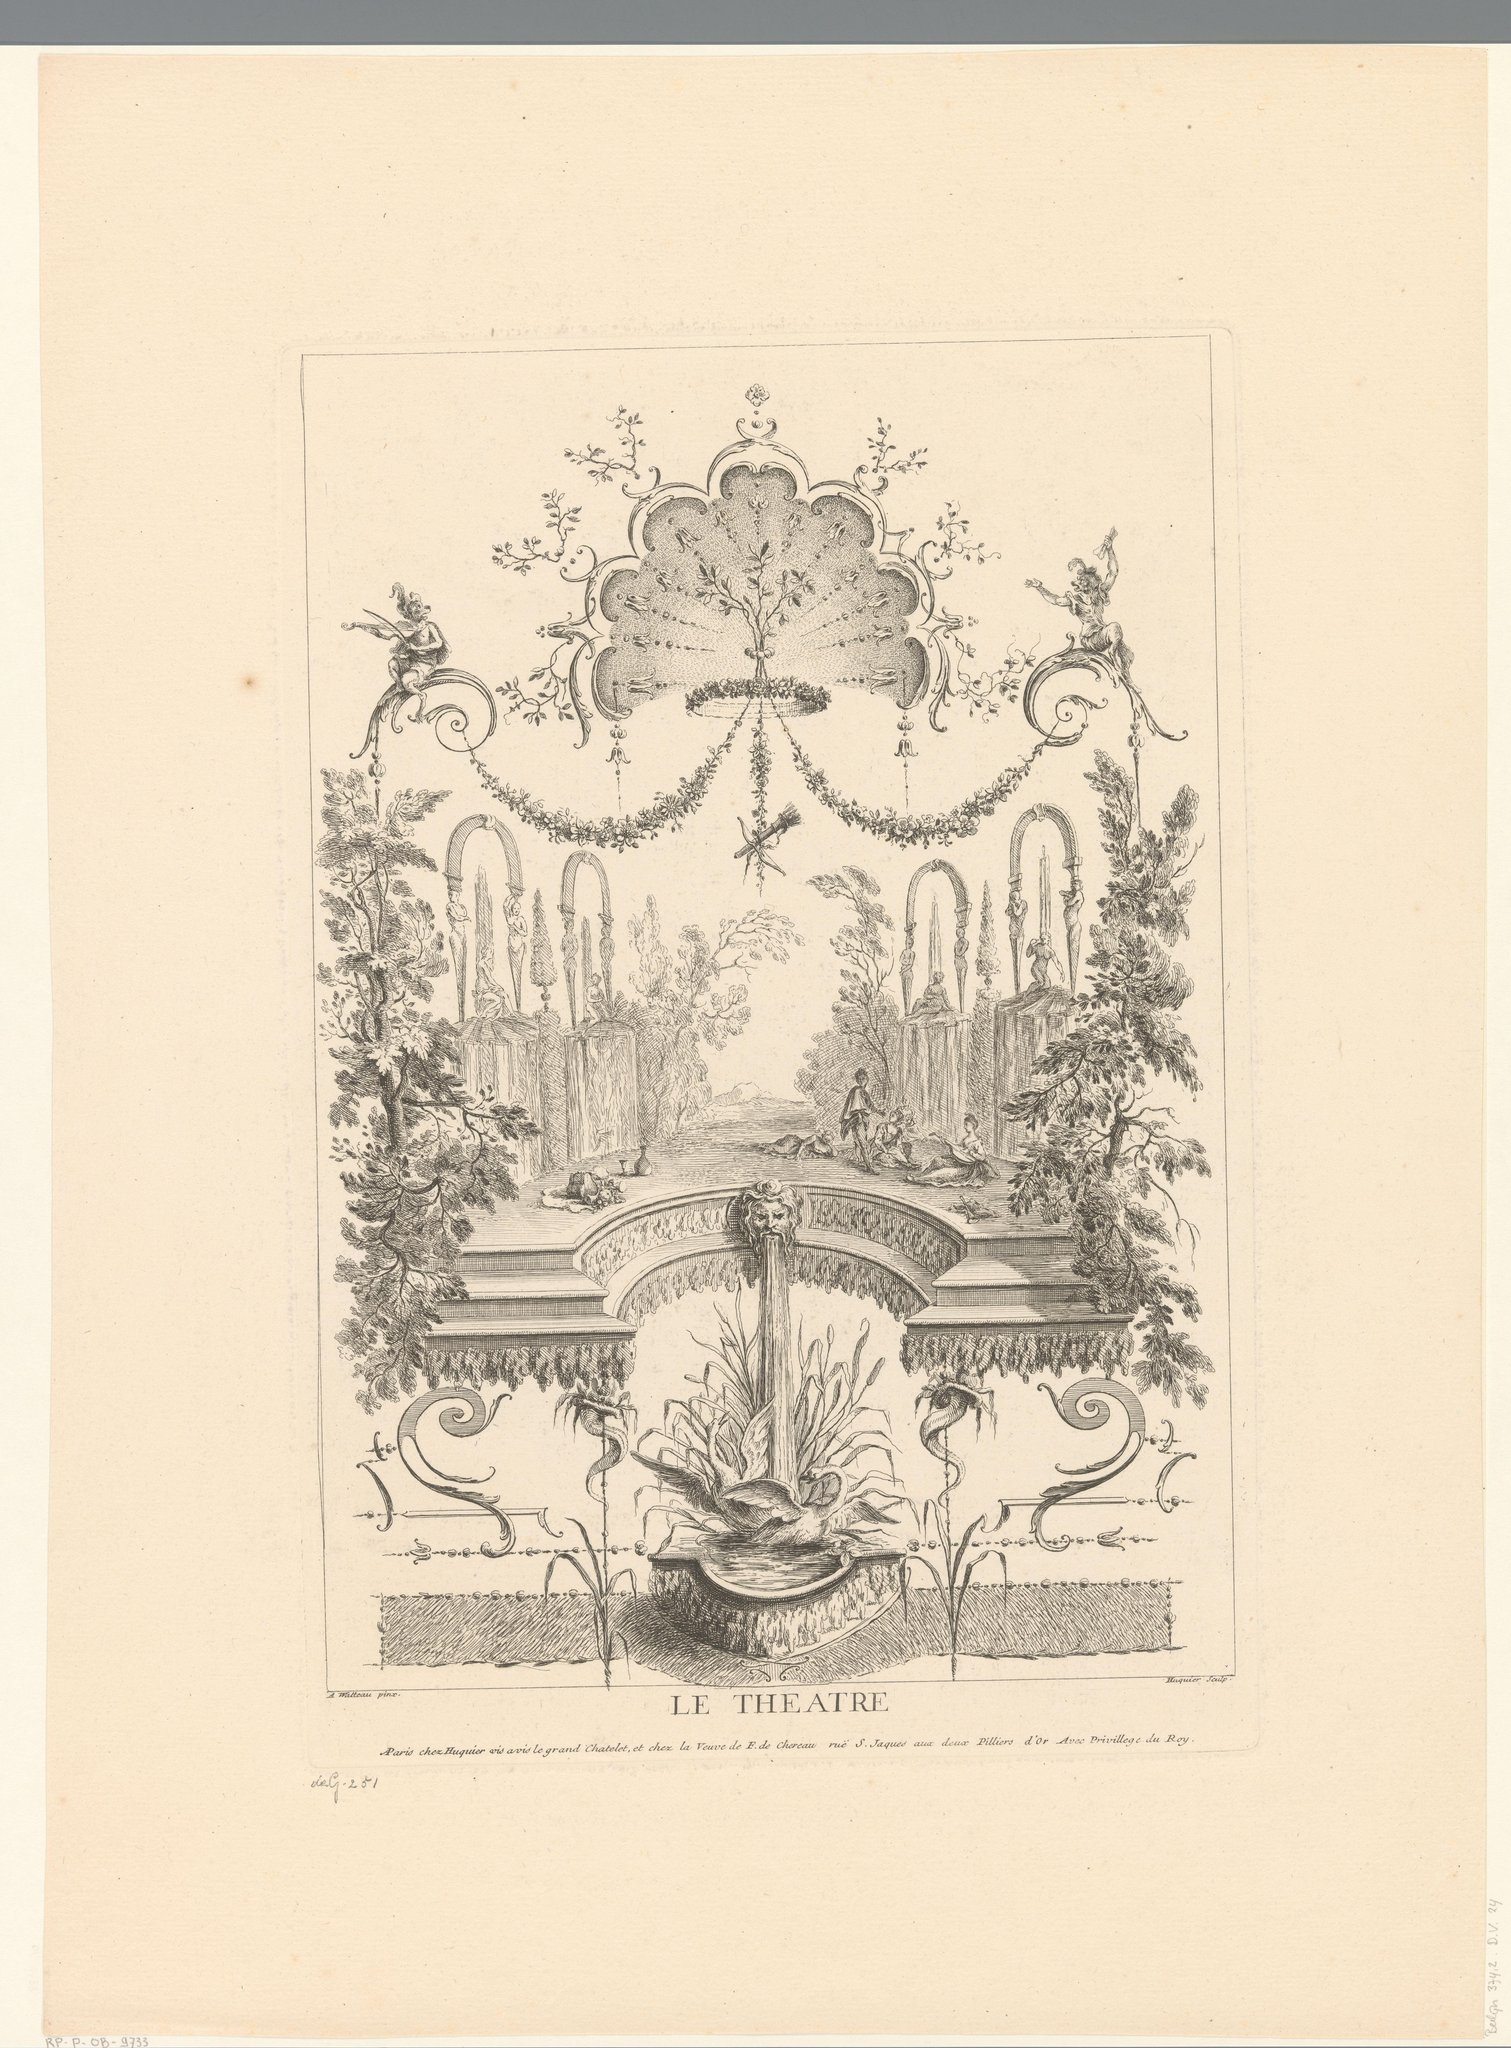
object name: ornament print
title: Theater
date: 1729-1737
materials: paper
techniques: etching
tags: symbolic representations, allegories and emblems ~ the theatre, garden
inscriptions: collector's mark: Lugt 2228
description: In een tuin met fonteinen en kariatiden zitten mensen te picknicken. Aan de bovenzijde ornementen met musicerende apen, guirlandes, een pijlenkoker en boog, een krans en een boom. De tuin loopt aan de voorzijde over in een trap met een fontein met een masker, lisdodden en zwanen geflankeerd door hoornen des overvloeds en ornamenten.